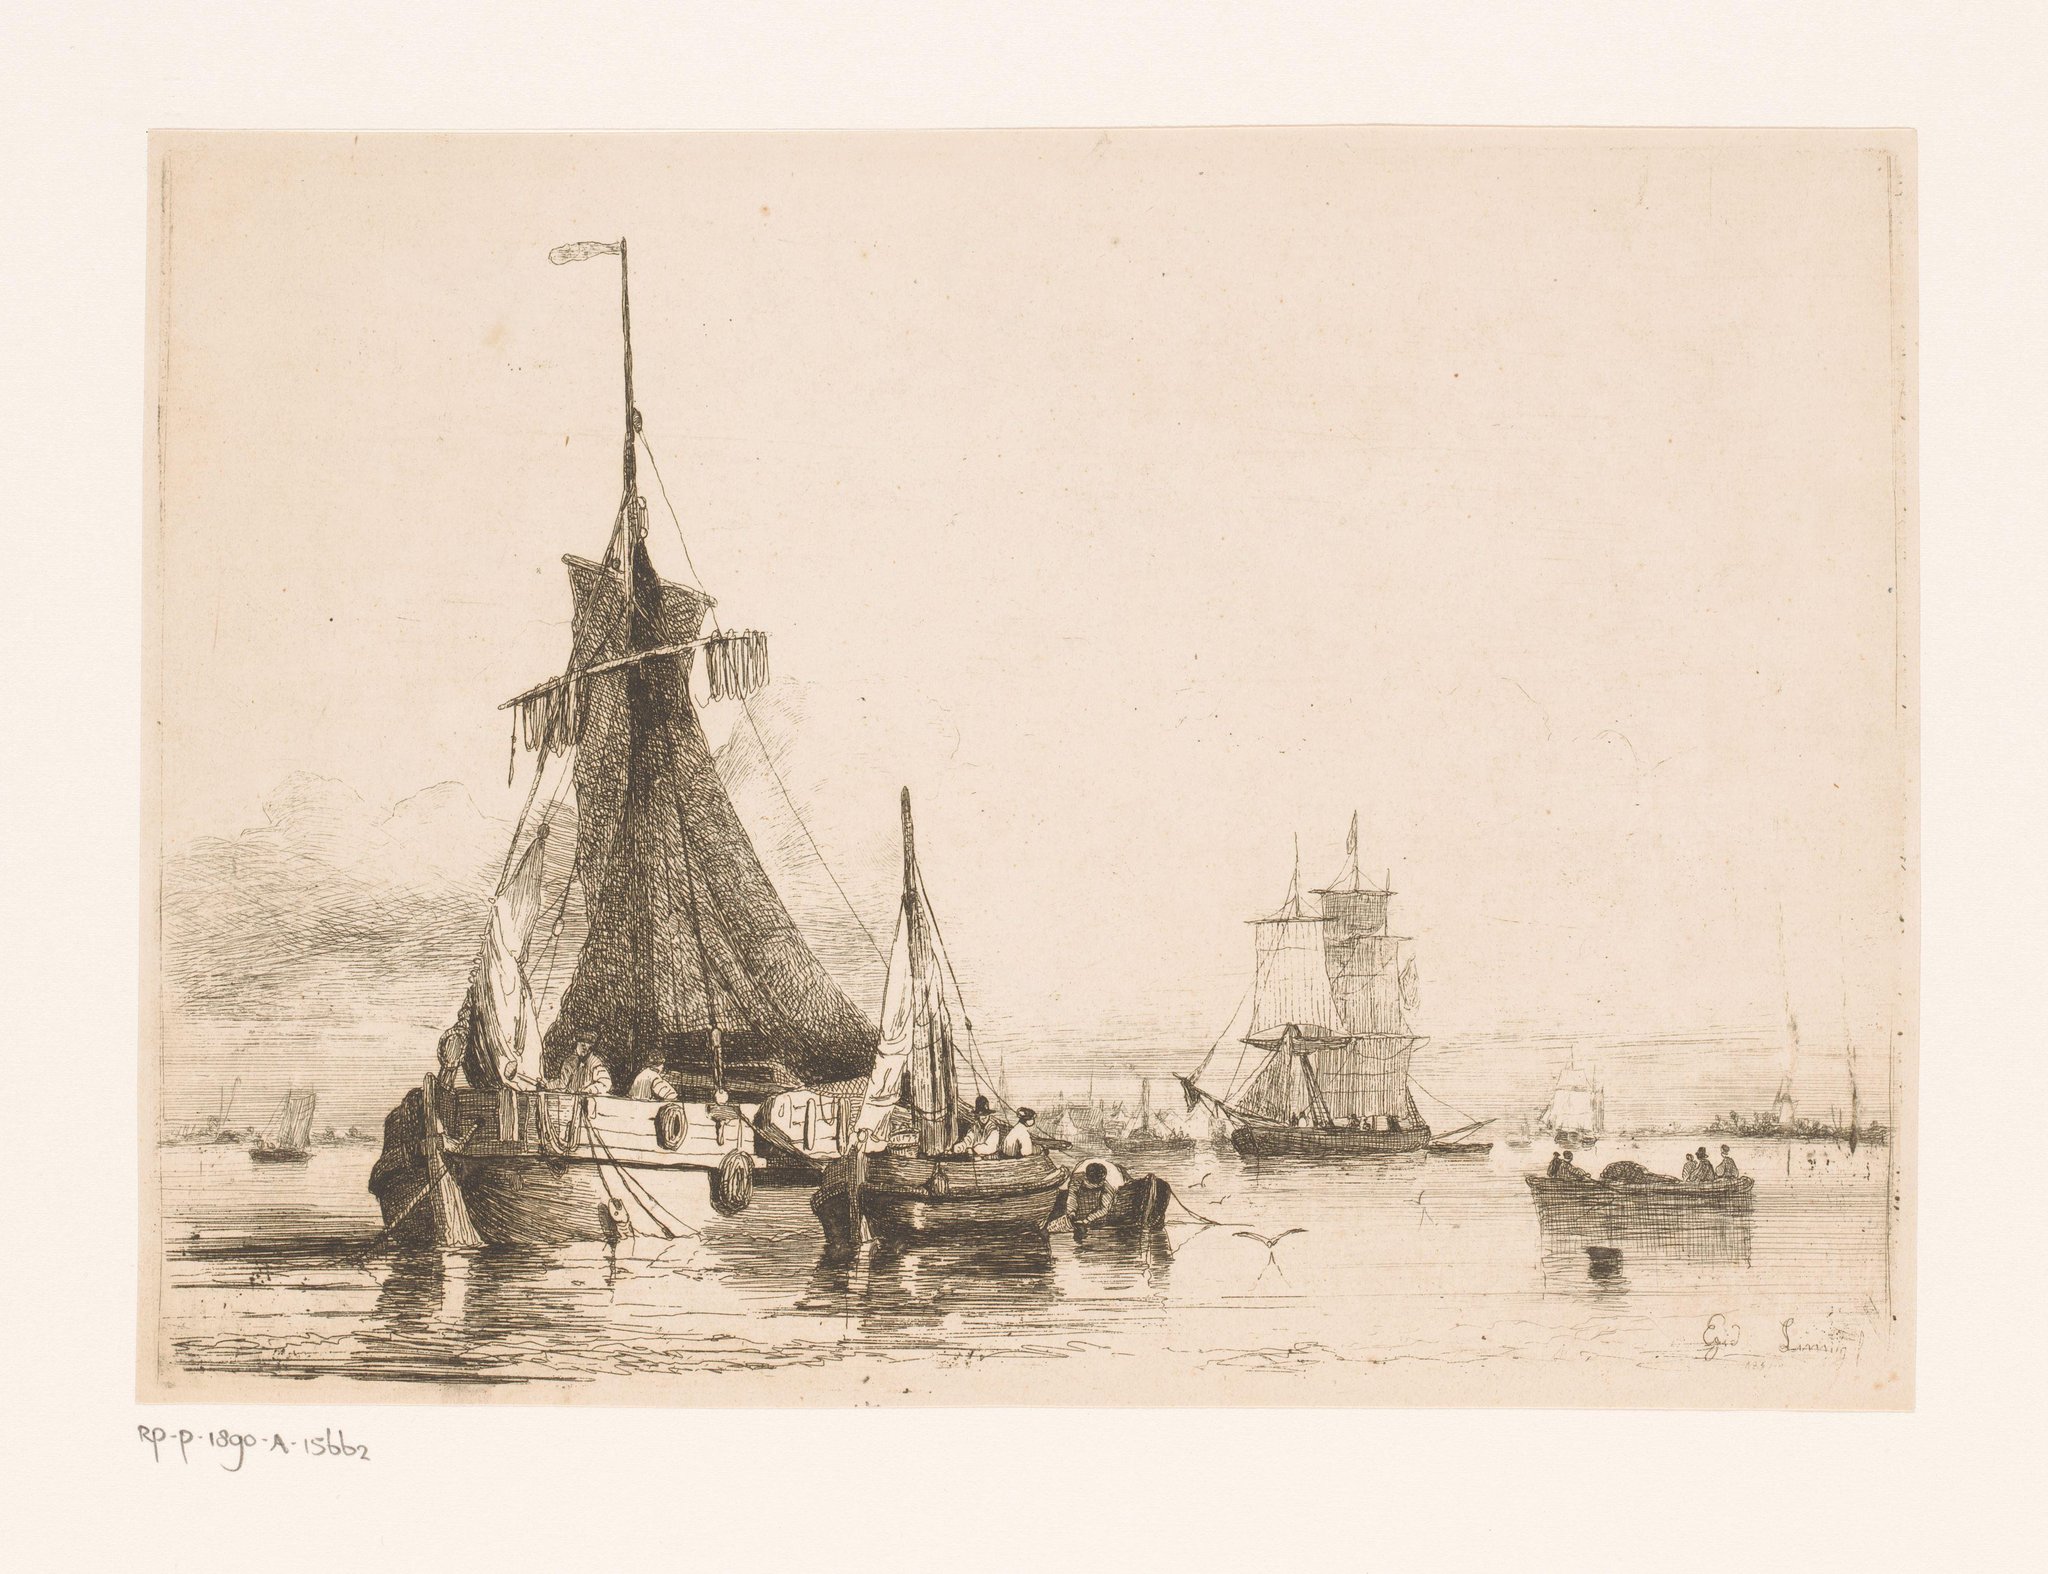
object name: print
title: Vissersboot op de Schelde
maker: egidius linnig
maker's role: draughtsman, print maker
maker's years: 1821-1860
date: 1841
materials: paper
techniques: etching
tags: sailing-ship, sailing-boat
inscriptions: collector's mark: Lugt 2228